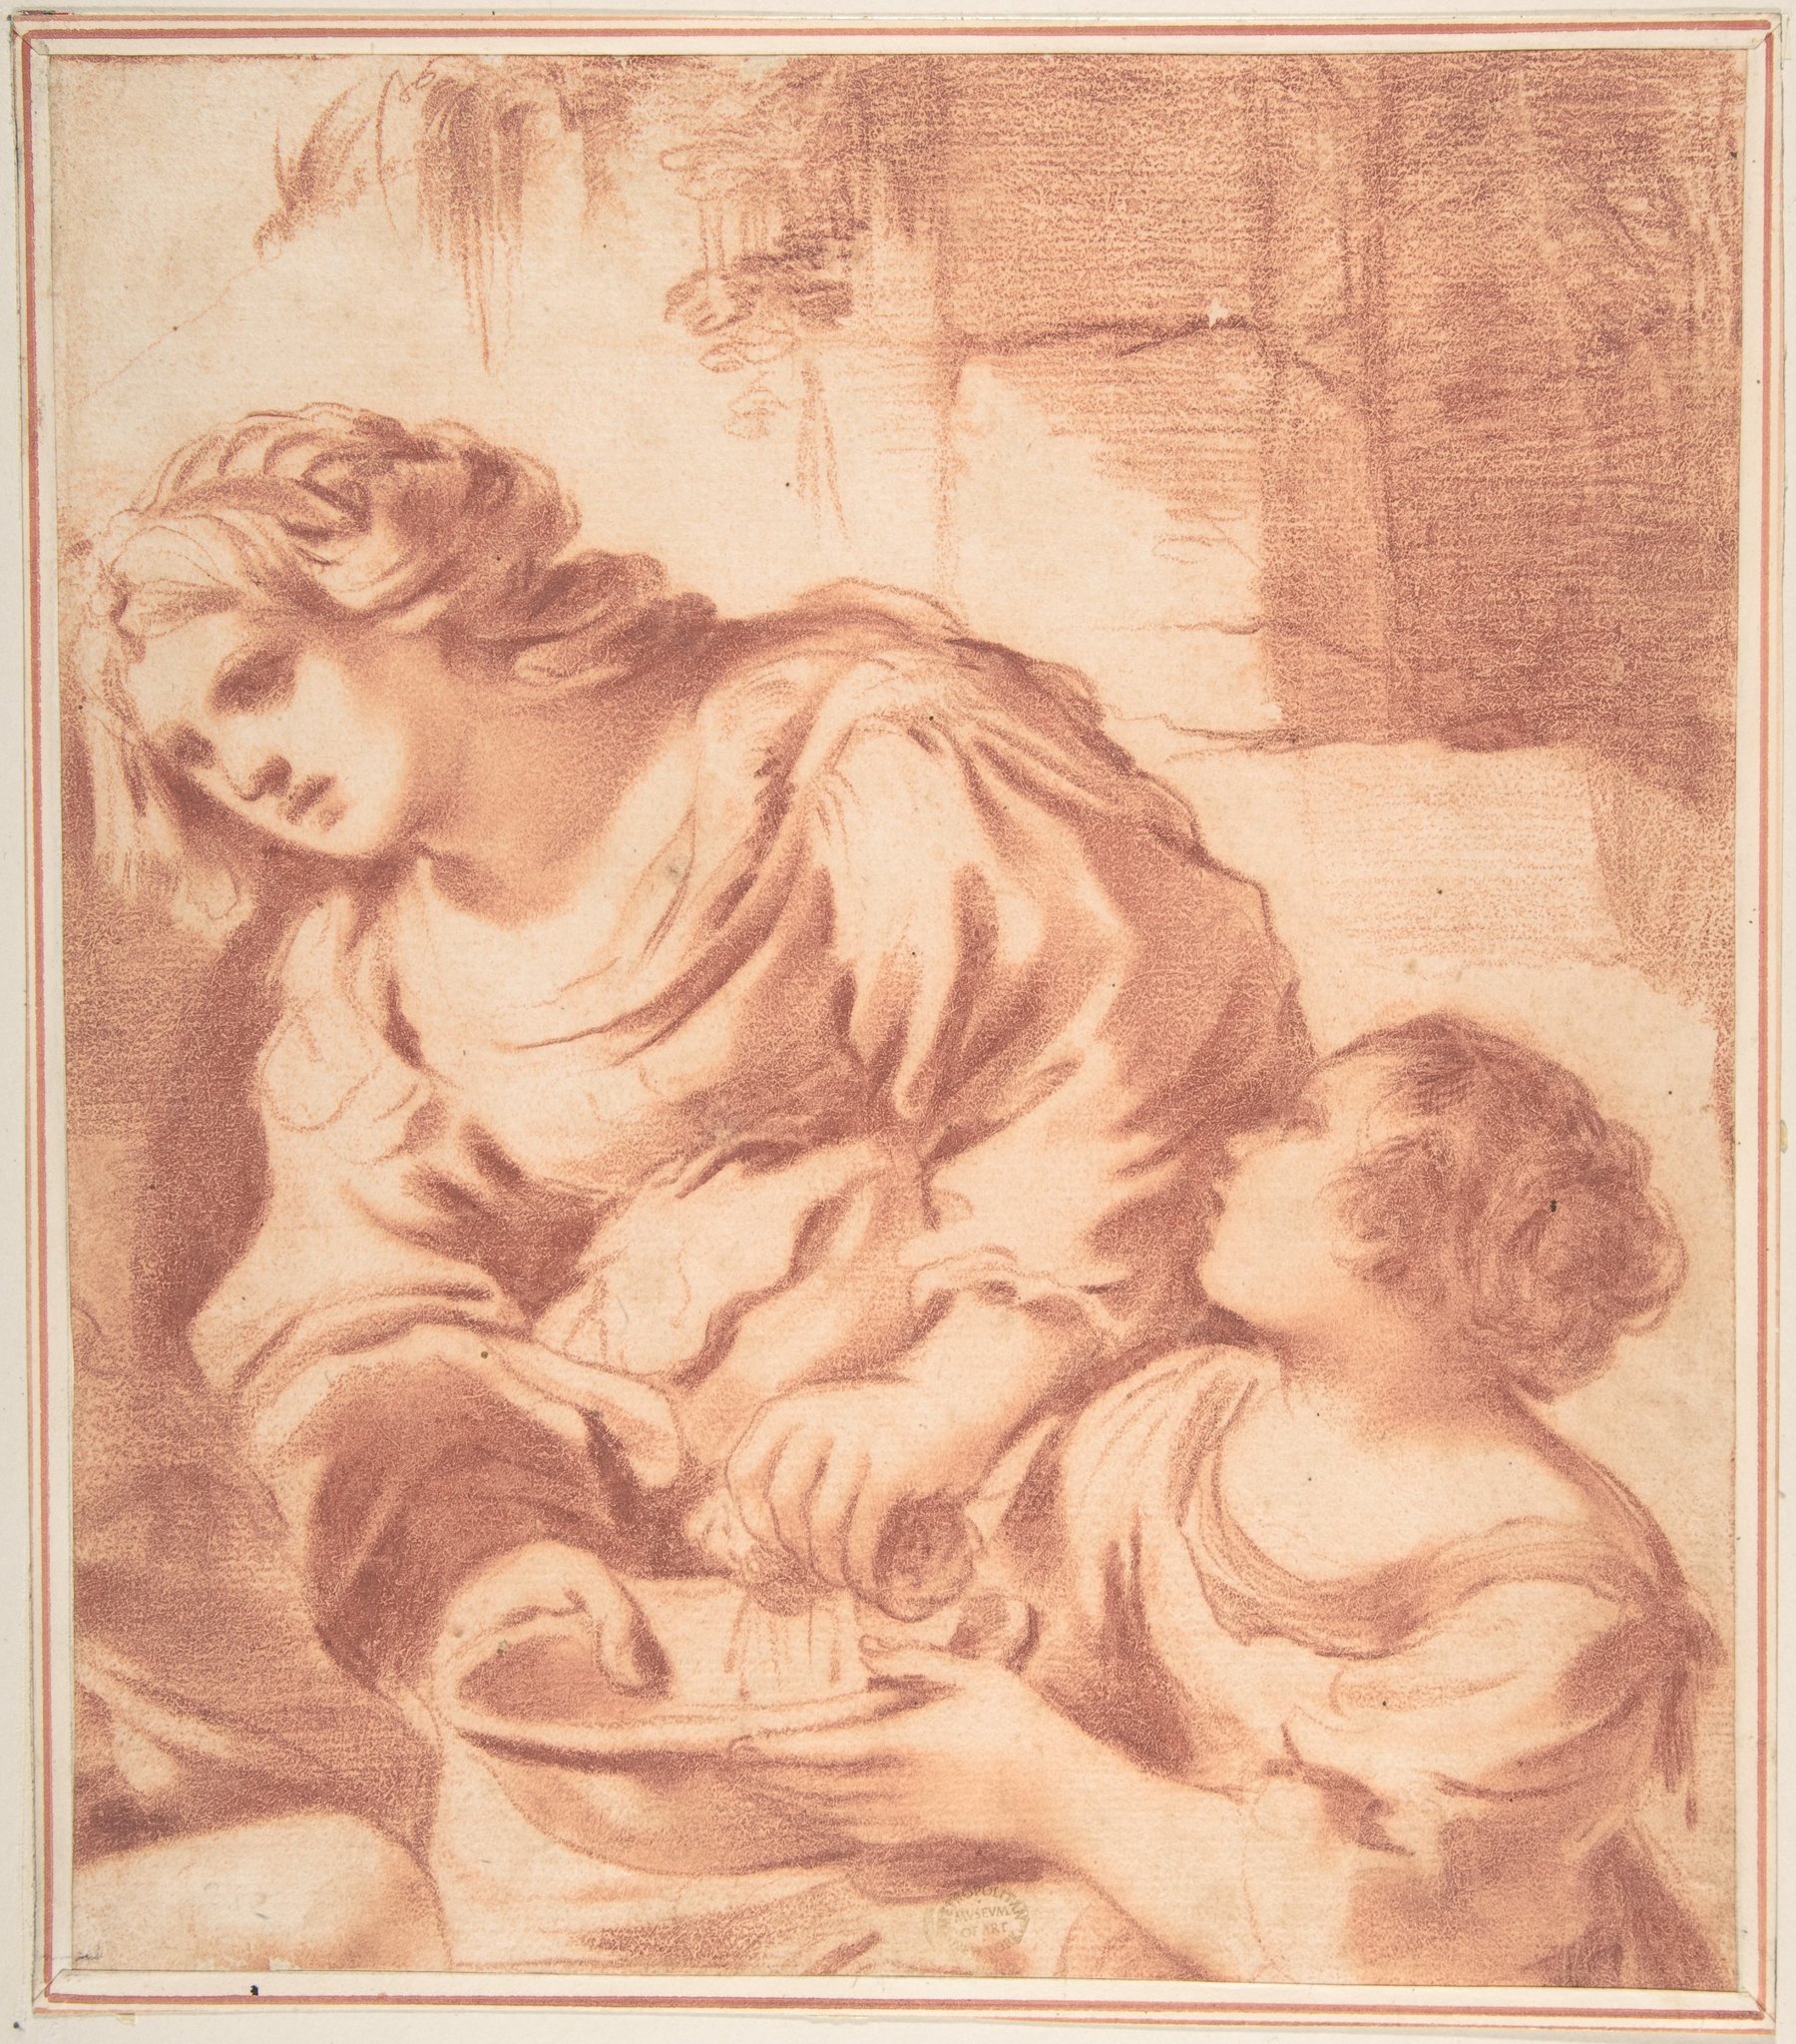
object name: drawing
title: Woman Soaking a Cloth in a Bowl Held by a Girl (copy from Guercino's Saint Sebastian Tended by Irene)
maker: guercino (giovanni francesco barbieri)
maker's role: artist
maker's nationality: italian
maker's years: 1591-1666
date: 1591-1666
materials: chalk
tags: girls,women,bowls